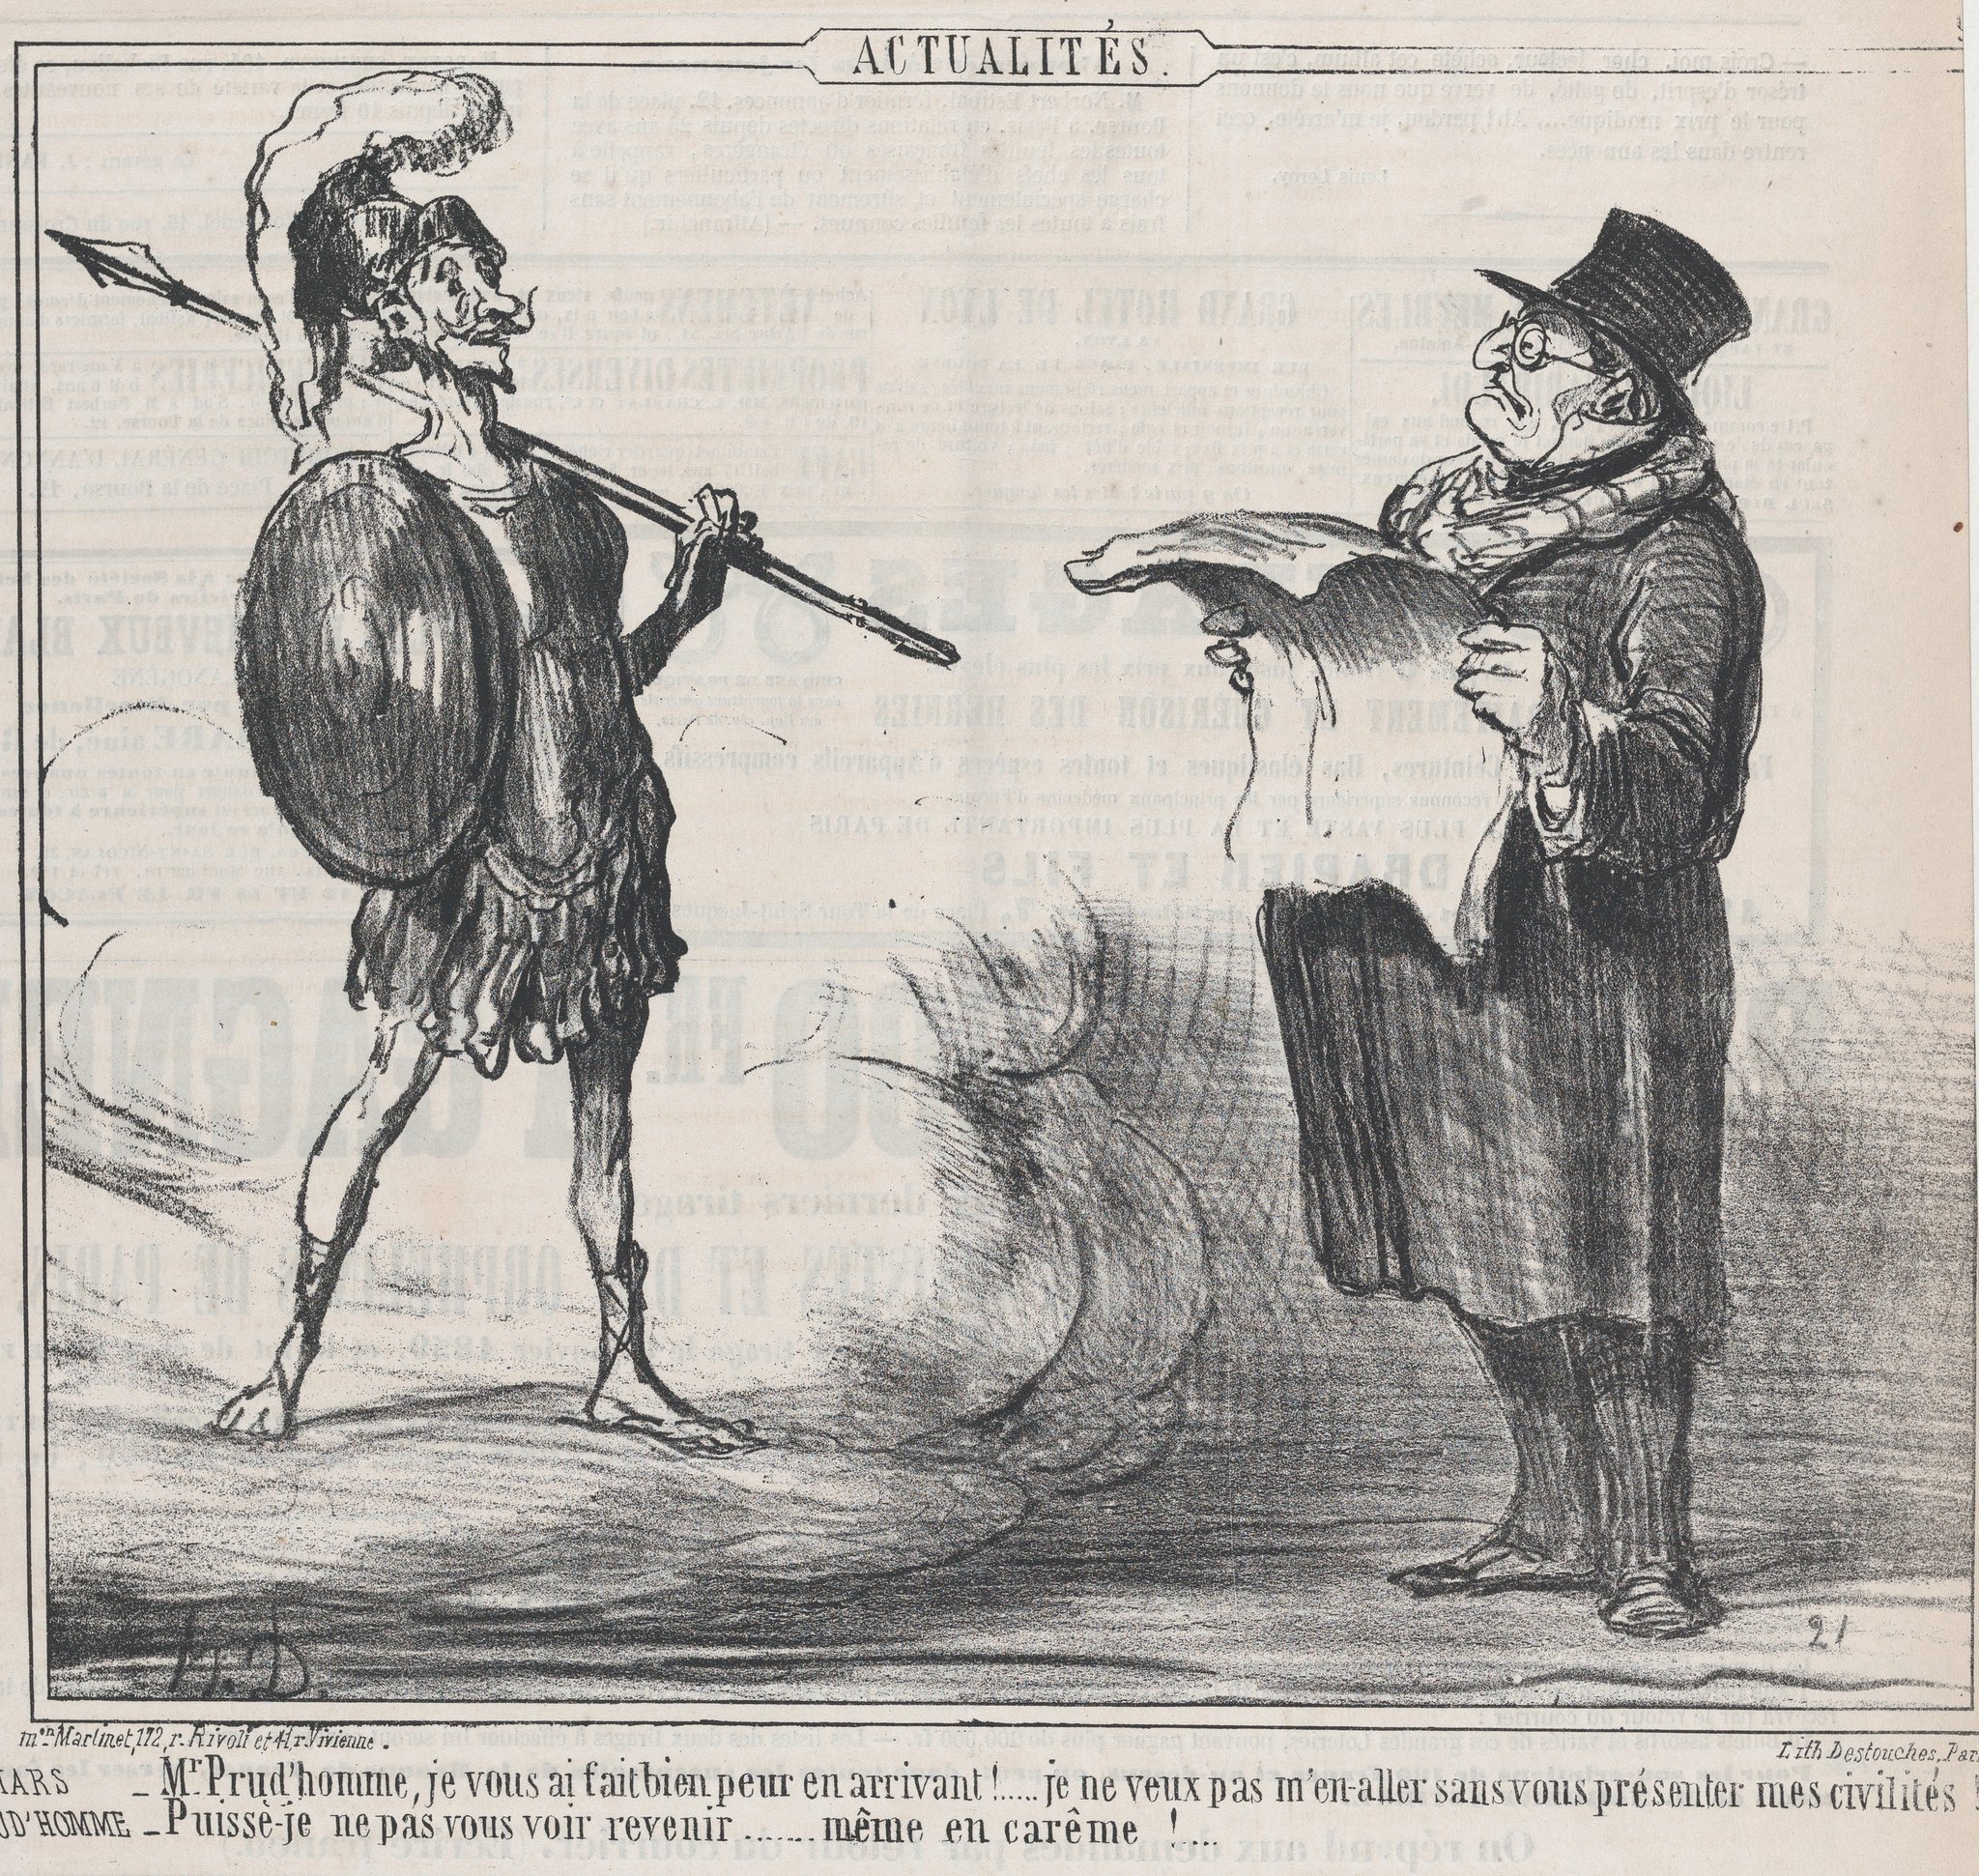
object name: print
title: Mars... Je vous ai fait bien peur..., from "Actualités"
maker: honoré daumier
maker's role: artist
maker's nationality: french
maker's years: 1808-1879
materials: paper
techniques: lithograph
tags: satire,shields,spears,men